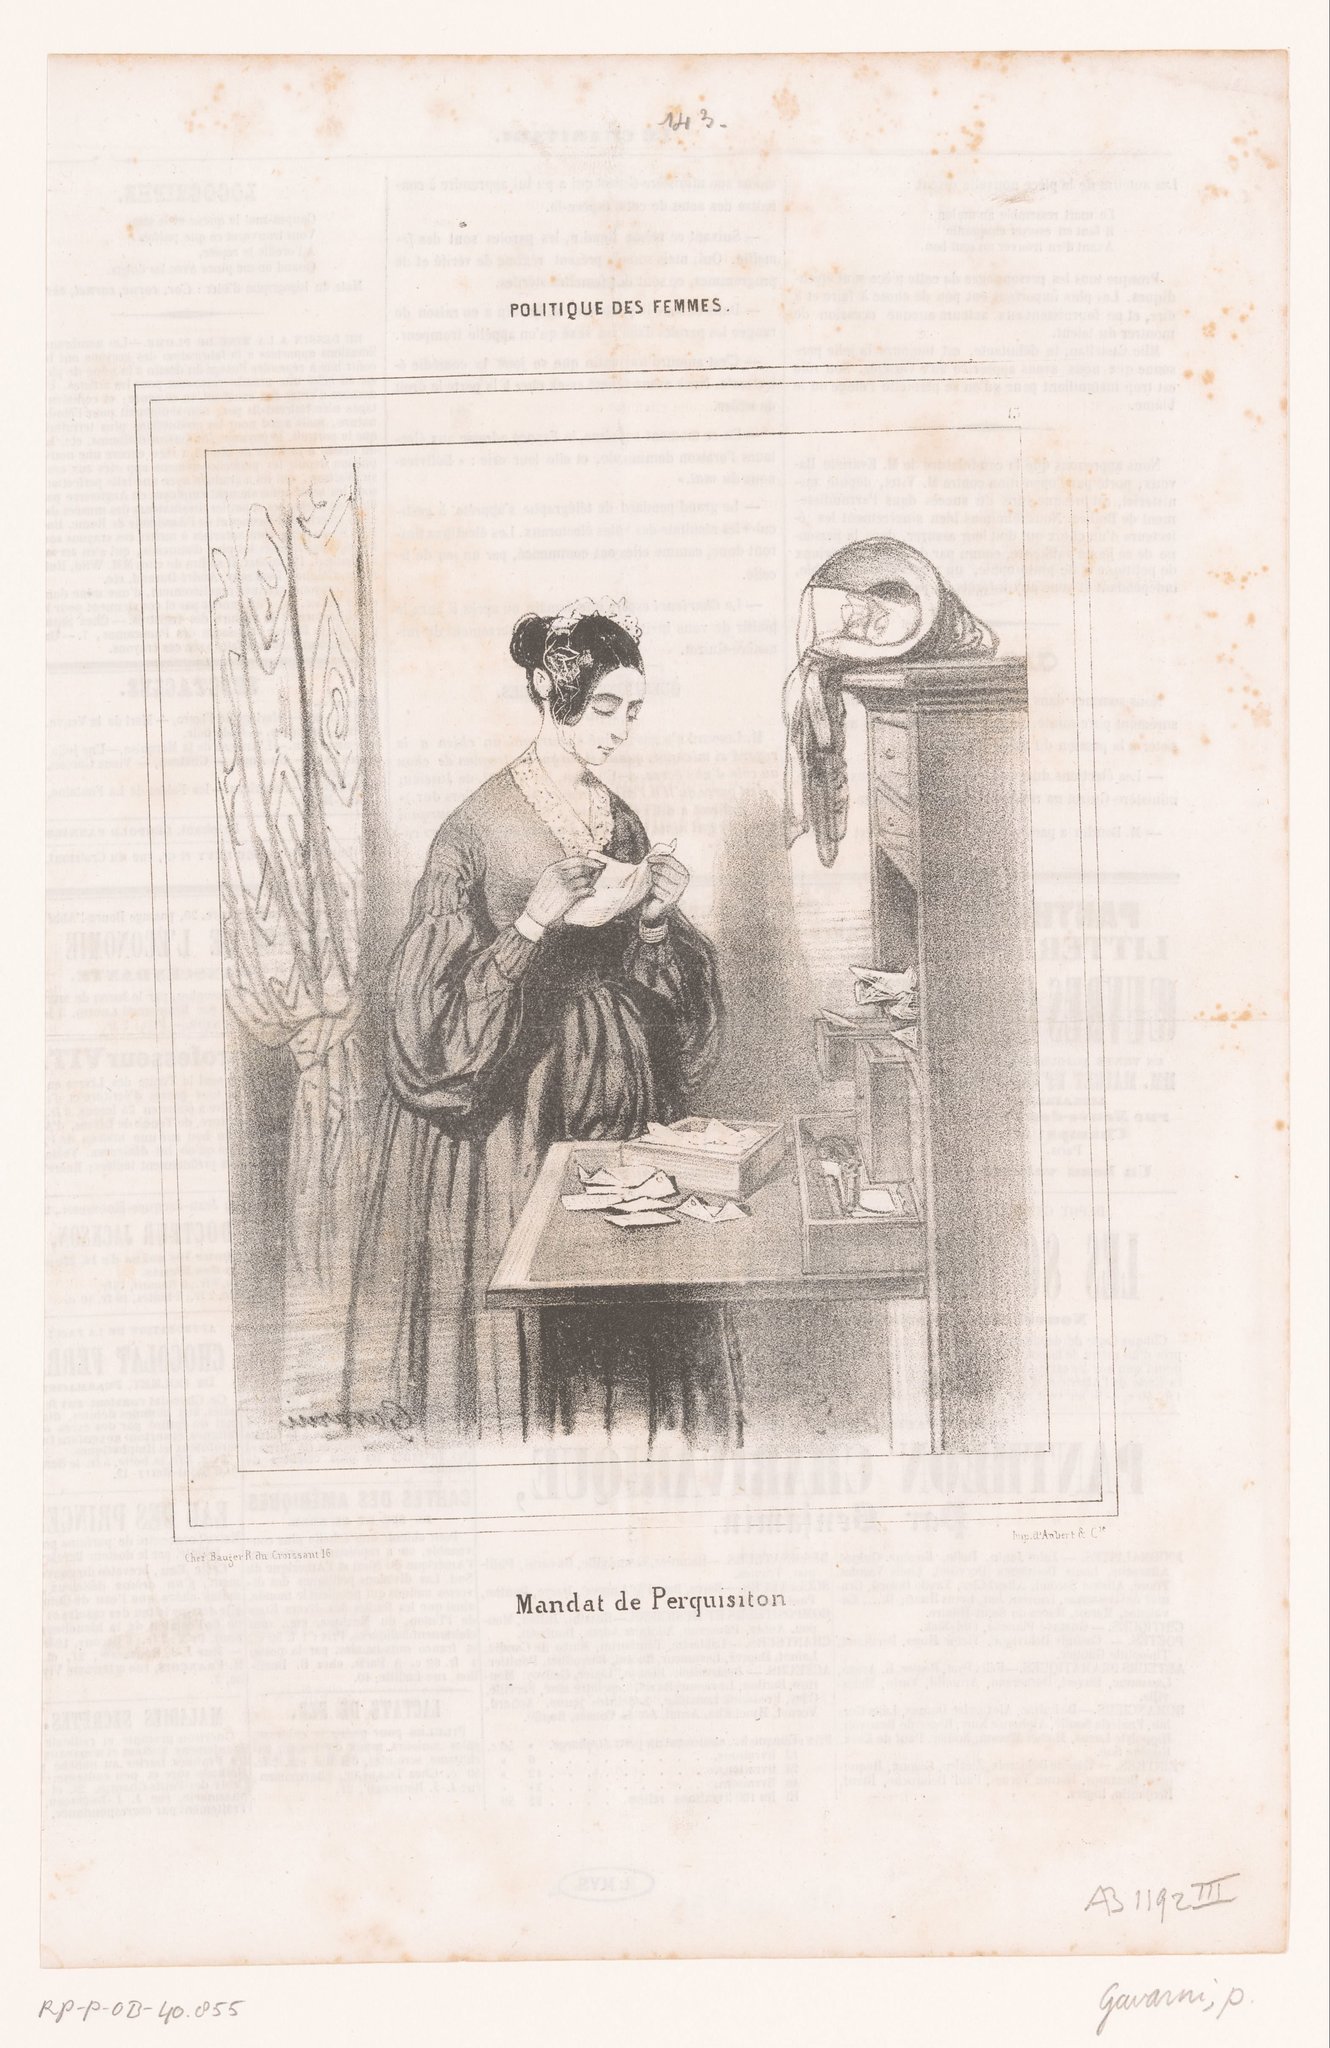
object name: cartoon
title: Politique des femmes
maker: paul gavarni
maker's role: draughtsman, print maker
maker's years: 1804-1866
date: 1842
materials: paper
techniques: lithograph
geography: paris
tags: writing-table, writing-desk, reading, standing figure - aa - female human figure, letter, envelope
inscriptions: collector's mark: Lugt 2228a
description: Prent gebruikt voor: Le Figaro, 12 september 1839, en voor: Le Charivari, 9 juli 1842.